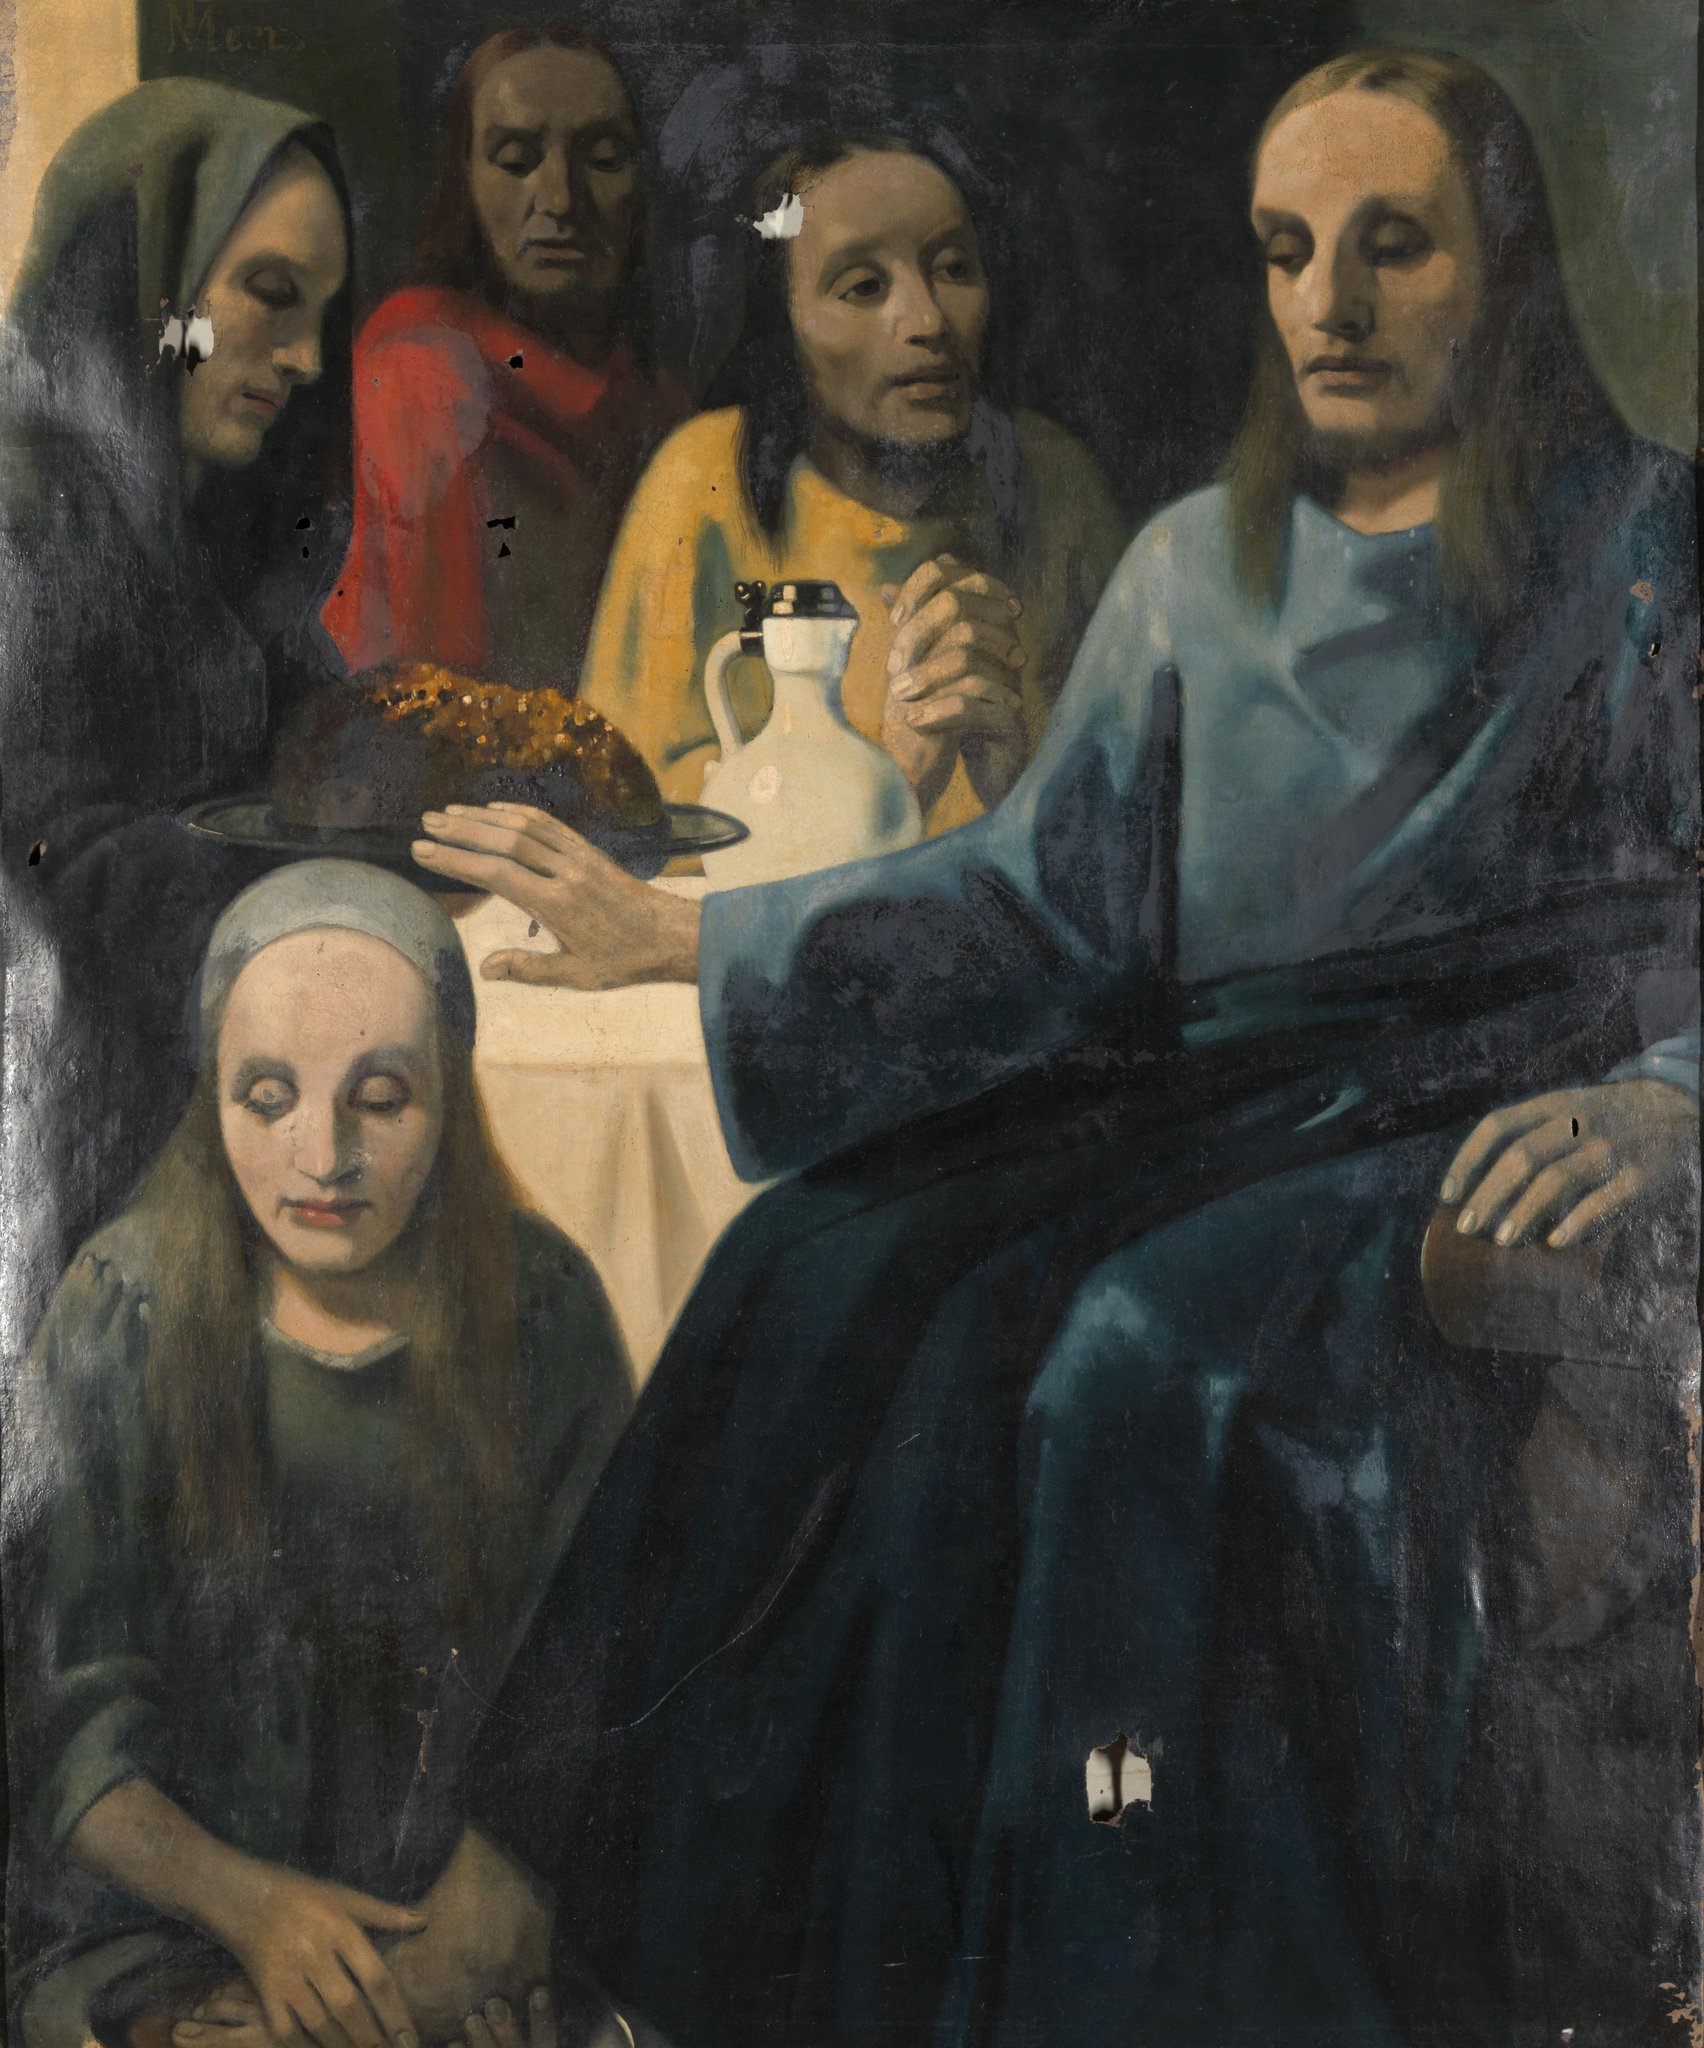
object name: painting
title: De voetwassing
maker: han van meegeren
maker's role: painter, print maker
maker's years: 1889-1947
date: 1935-1943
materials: canvas, oil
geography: netherlands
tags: christ's feet are anointed by mary (magdalene)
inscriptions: signature (false): ‘IVMeer’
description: De voetwassing. Maria zalft de voeten van Christus, geschilderd in de trant van Johannes Vermeer.